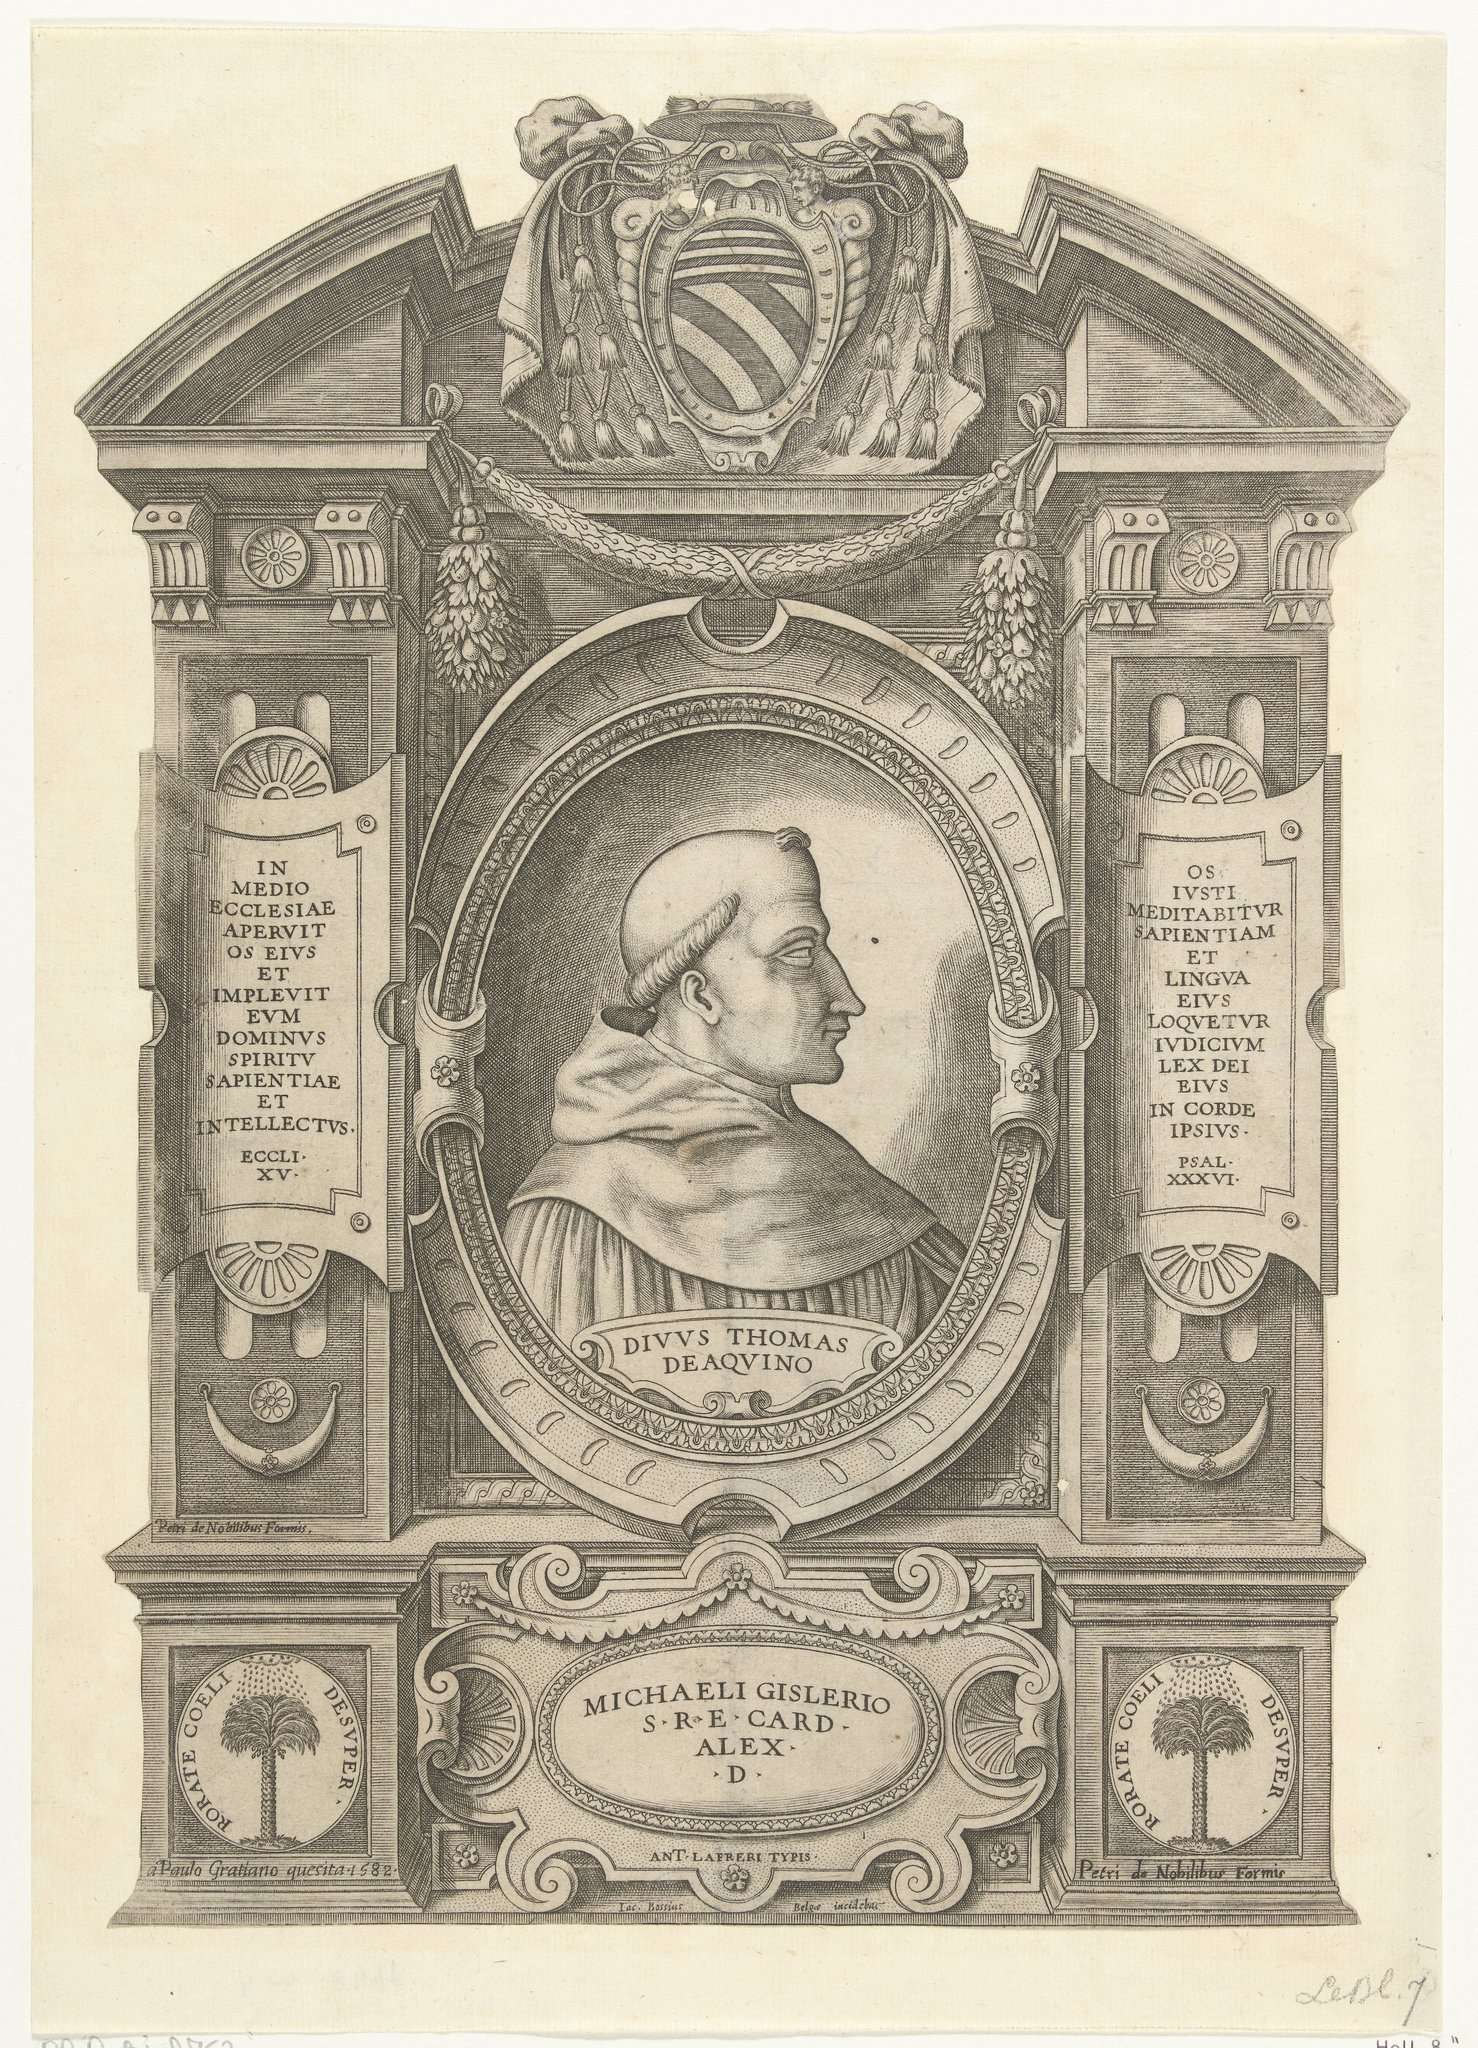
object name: print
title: Thomas van Aquino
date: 1584-1585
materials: paper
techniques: engraving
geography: rome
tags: the dominican theologian, 'angelic doctor' thomas of aquino; possible attributes: book, (chain with) sun, dove, girdle of chastity, lily, model of church, monstrance (or chalice), mitre (under feet), star (on breast)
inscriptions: collector's mark: Lugt 2228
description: Portret van Thomas van Aquino. Ovaal medaillon met buste naar rechts. De scholastische wijsgeer Thomas van Aquino heeft een monnikenpij aan. Twee cartouches links en rechts van het portret met Latijnse opschriften. Bovenaan een wapenschild. Onderaan een cartouche met een toewijding aan Cardinaal Michael Ghisleri.